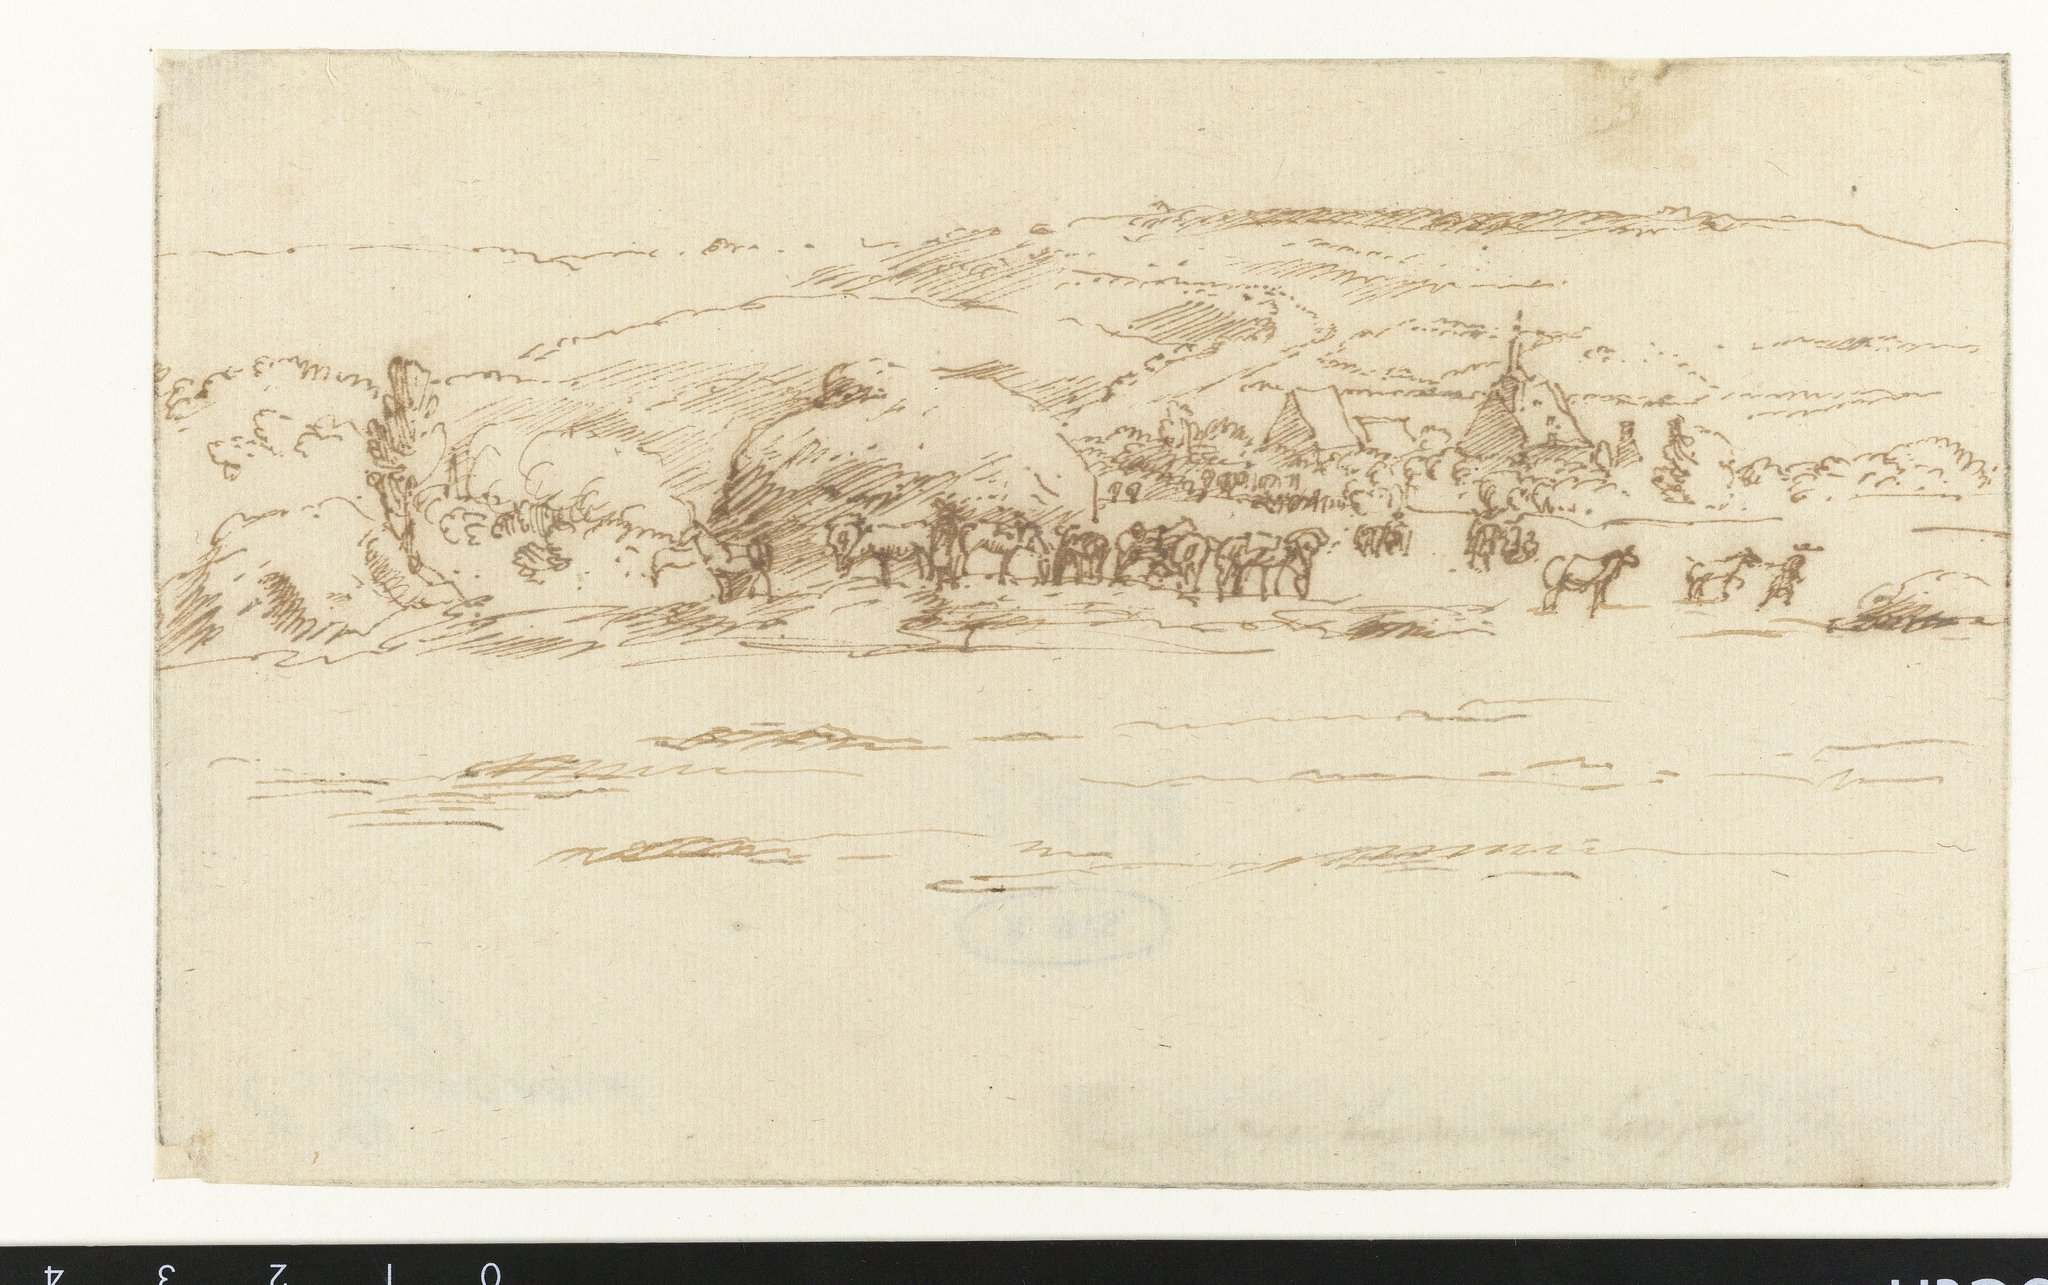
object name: drawing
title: Bij Charleroi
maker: constantijn huygens (ii)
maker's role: draughtsman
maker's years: 1628-1697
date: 1677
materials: ink, paper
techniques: pen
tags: the hague, william iii (prince of orange and king of england, scotland, and ireland), raising the siege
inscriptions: inscription: ‘Int opbreken van voor Charleroi. 14.aug.1677.’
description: Afbreken van het beleg van Charleroi en terugtocht van de troepen van Willem III, 14 augustus 1677.